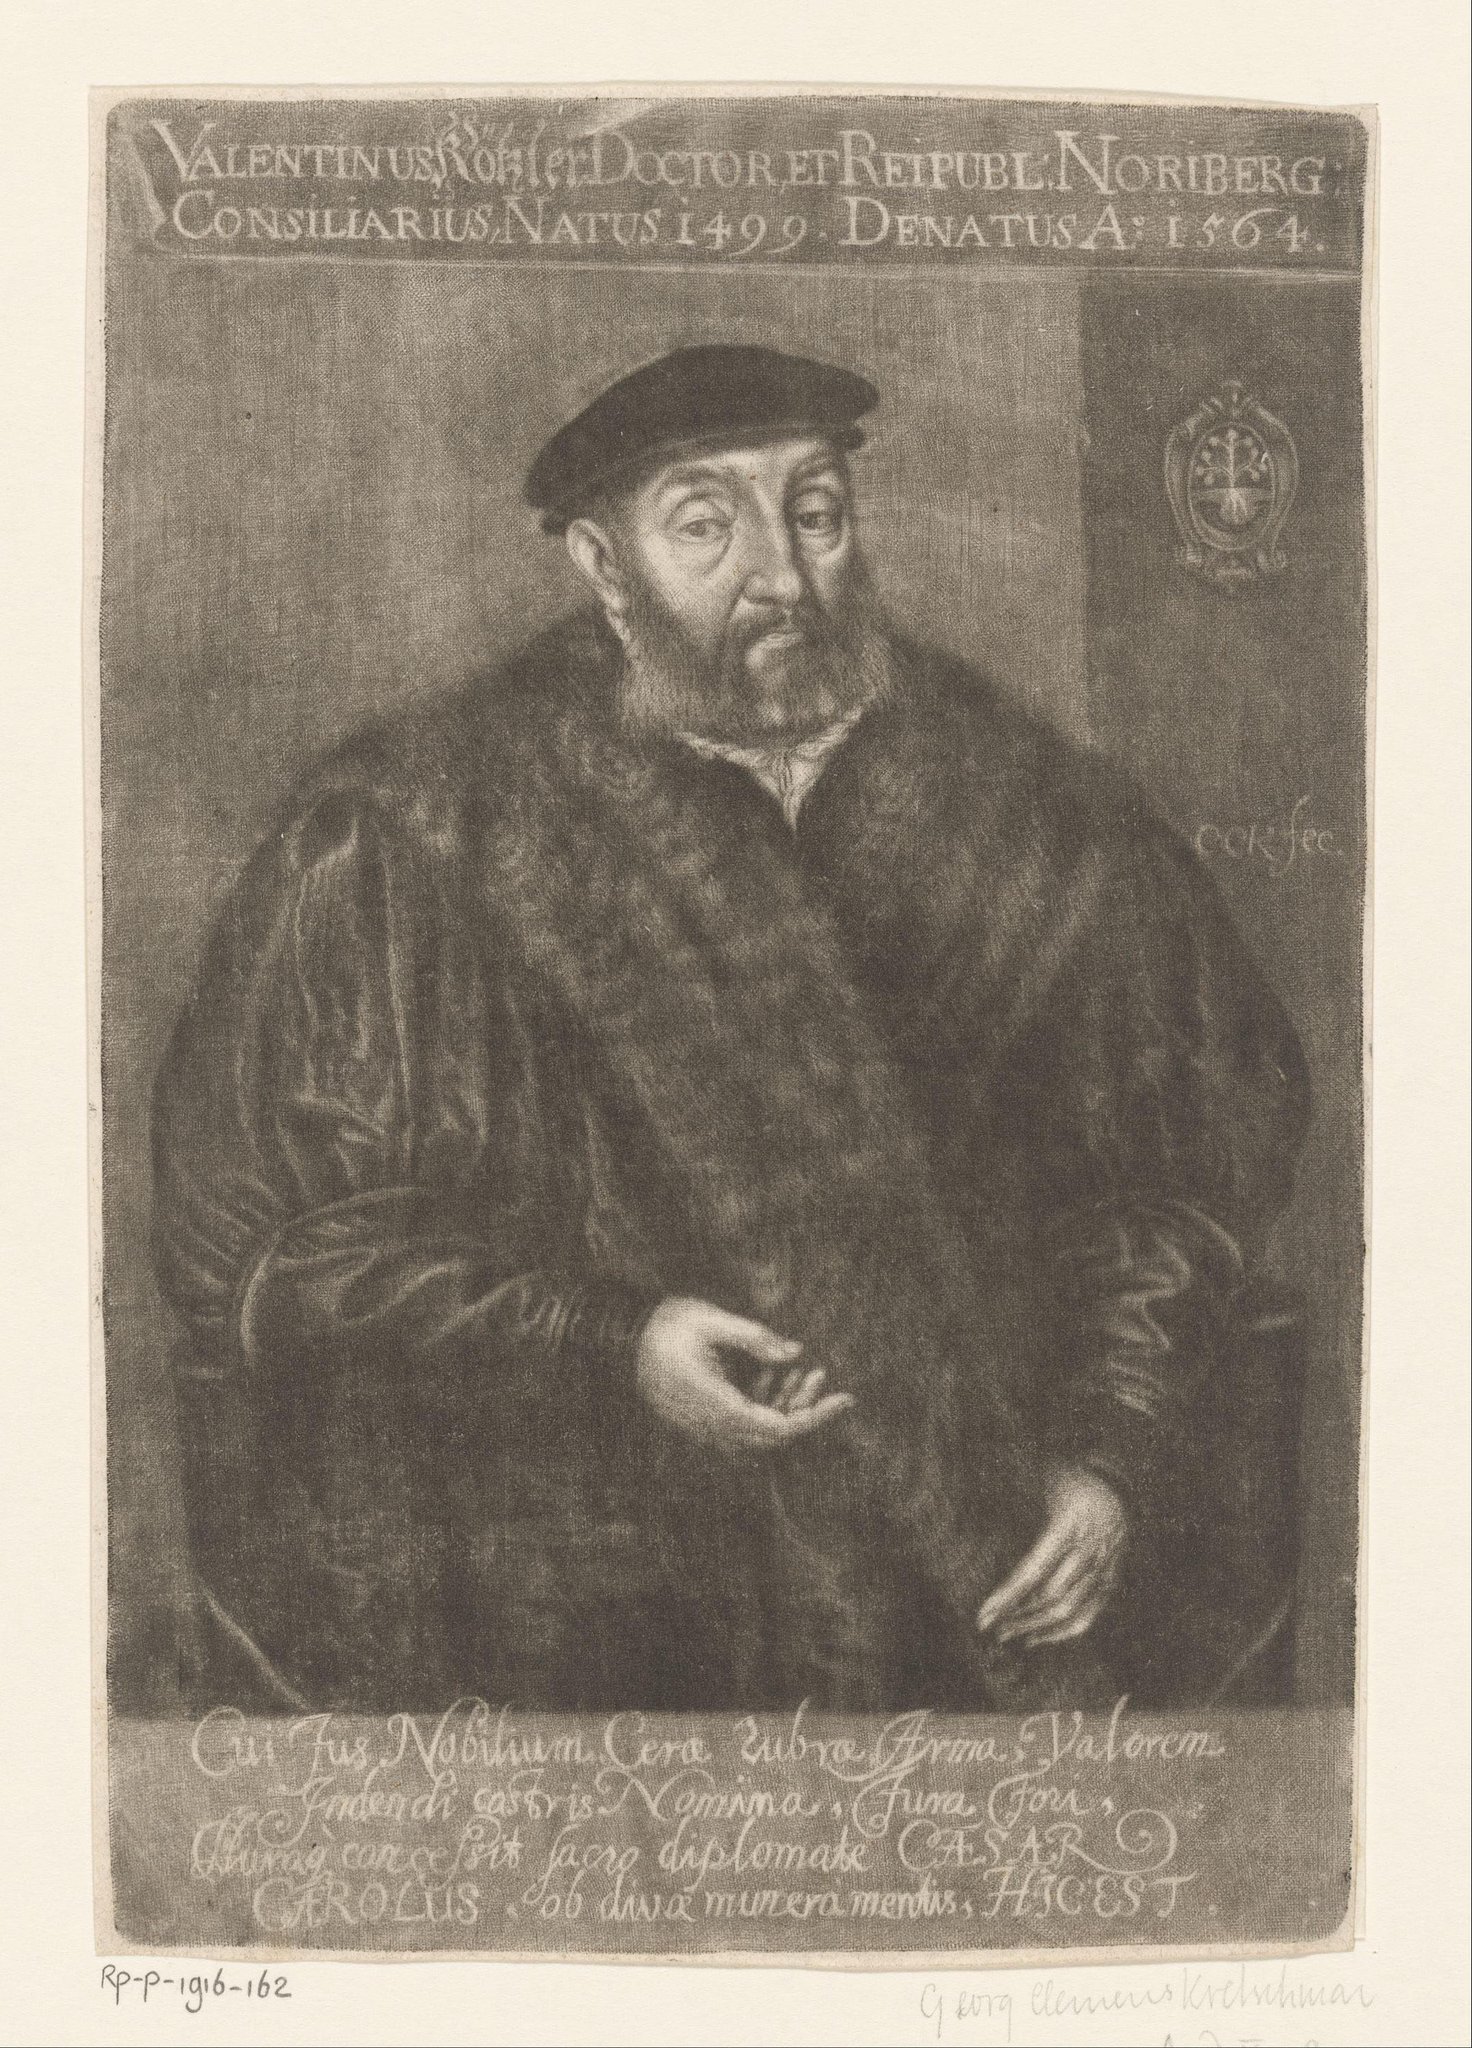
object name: print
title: Portret van Valentin Kötzler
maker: carl clemens kretschmann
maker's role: print maker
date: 1690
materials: paper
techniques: mezzotint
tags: historical persons, armorial bearing, heraldry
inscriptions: collector's mark: Lugt 2228